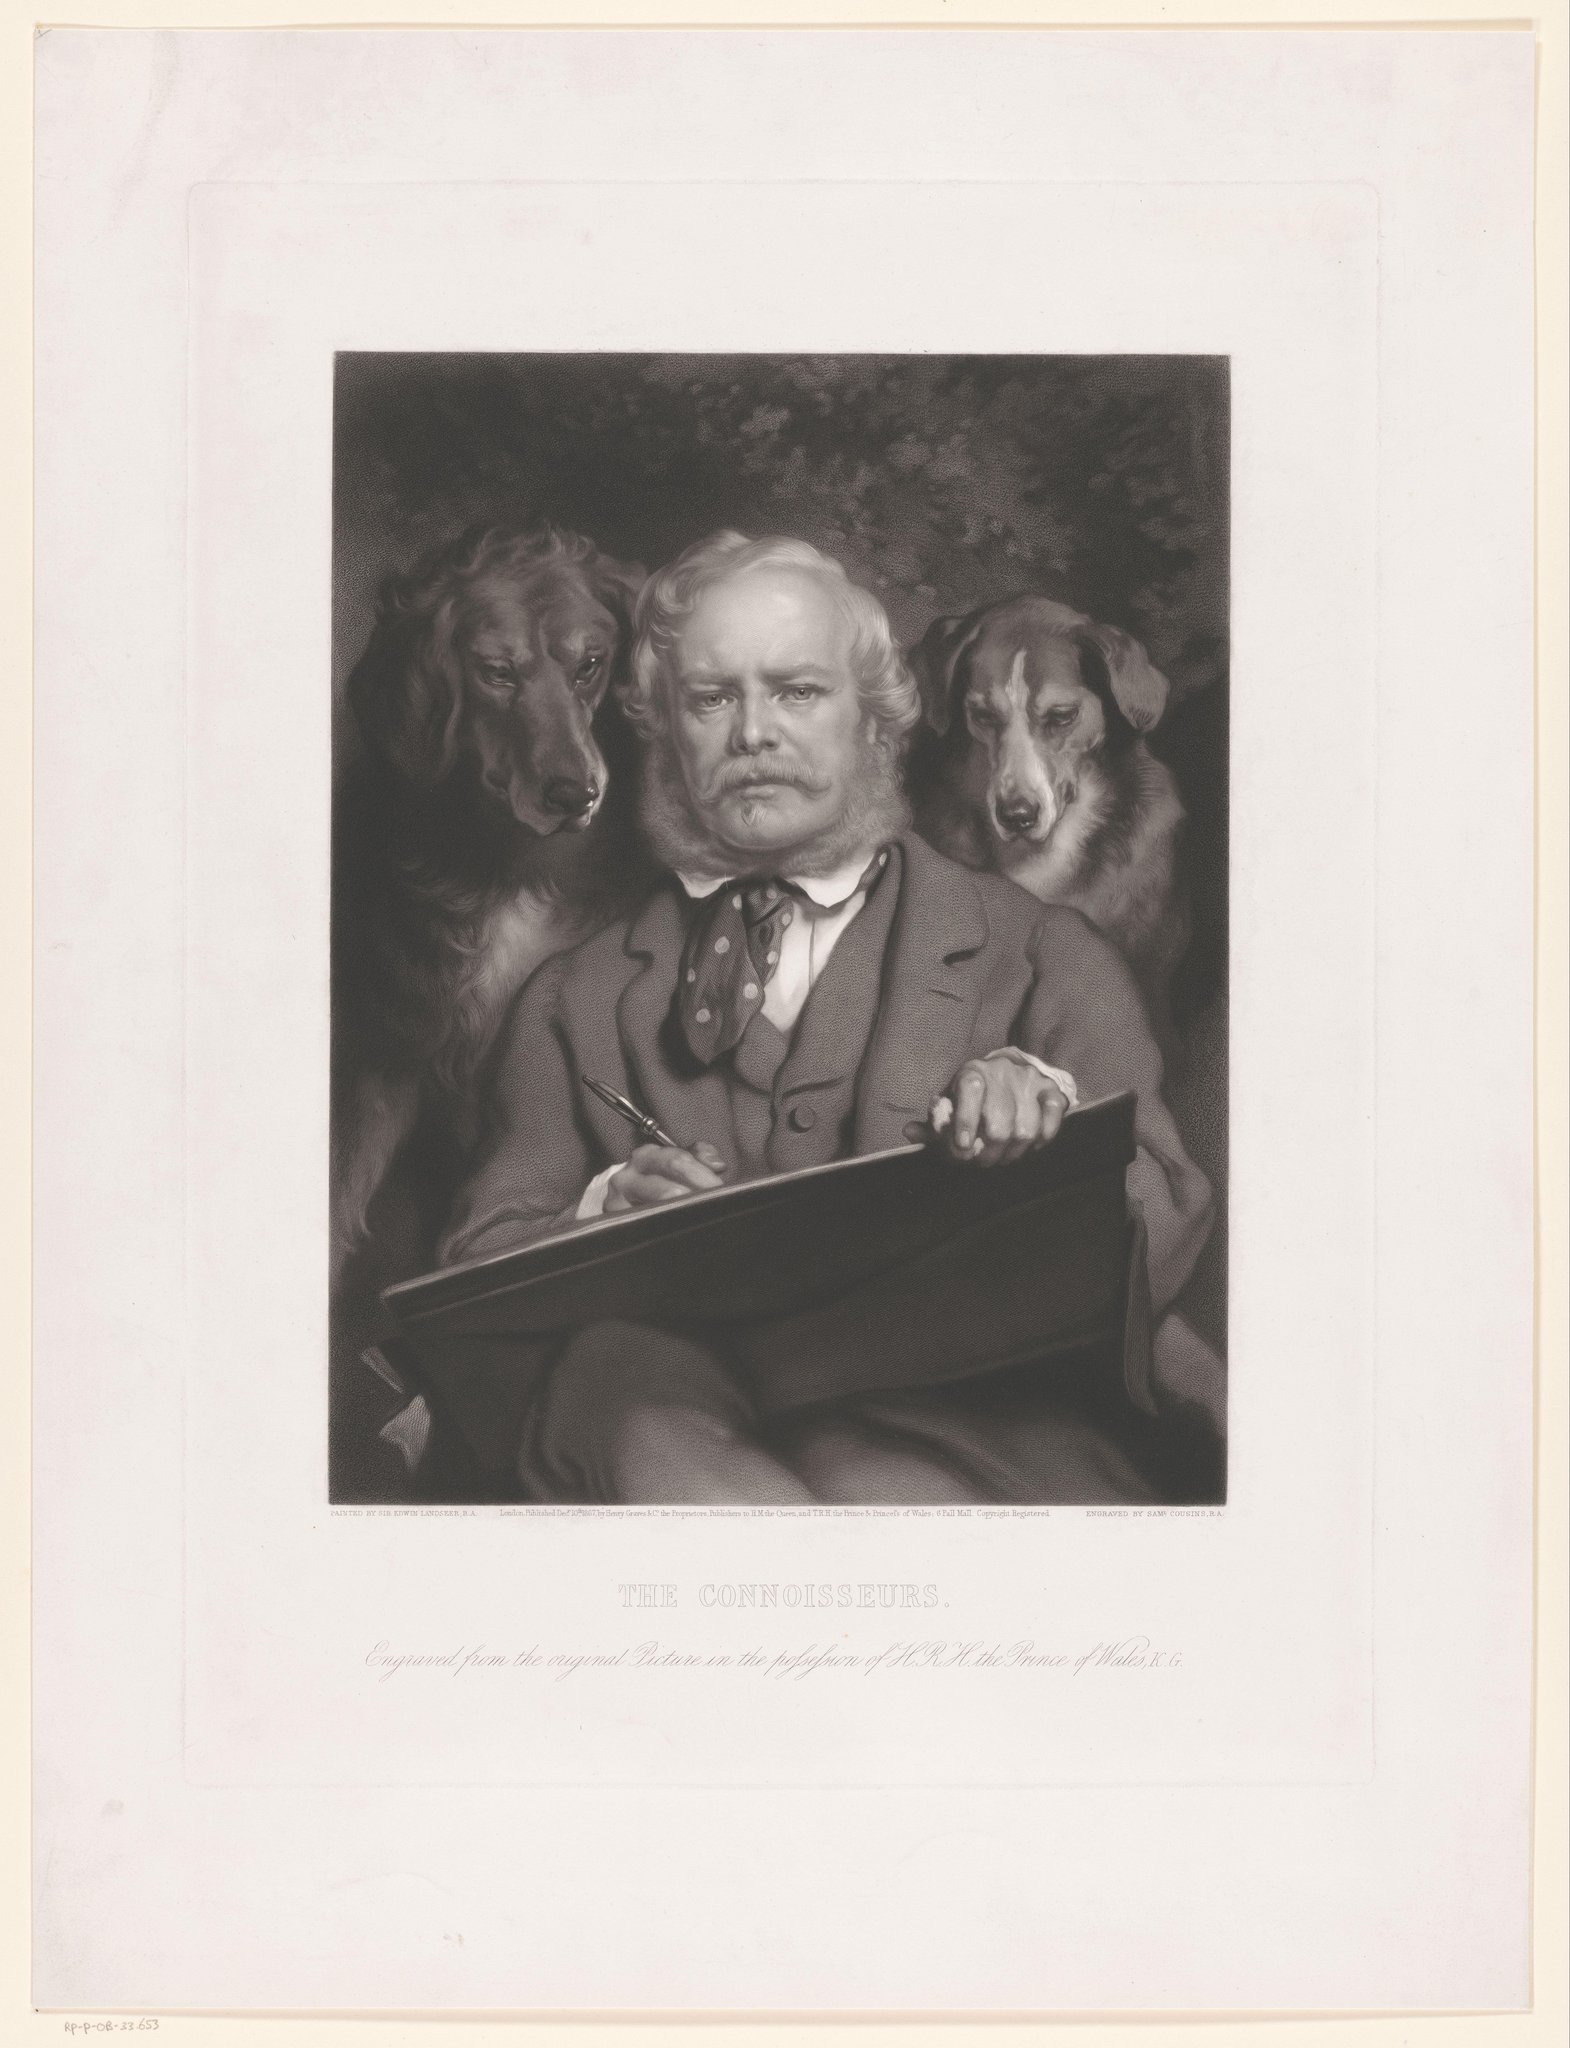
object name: print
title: The Connnoisseurs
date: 1812-1867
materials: paper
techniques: etching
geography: london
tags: draughtsman at work, dog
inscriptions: collector's mark: Lugt 2228